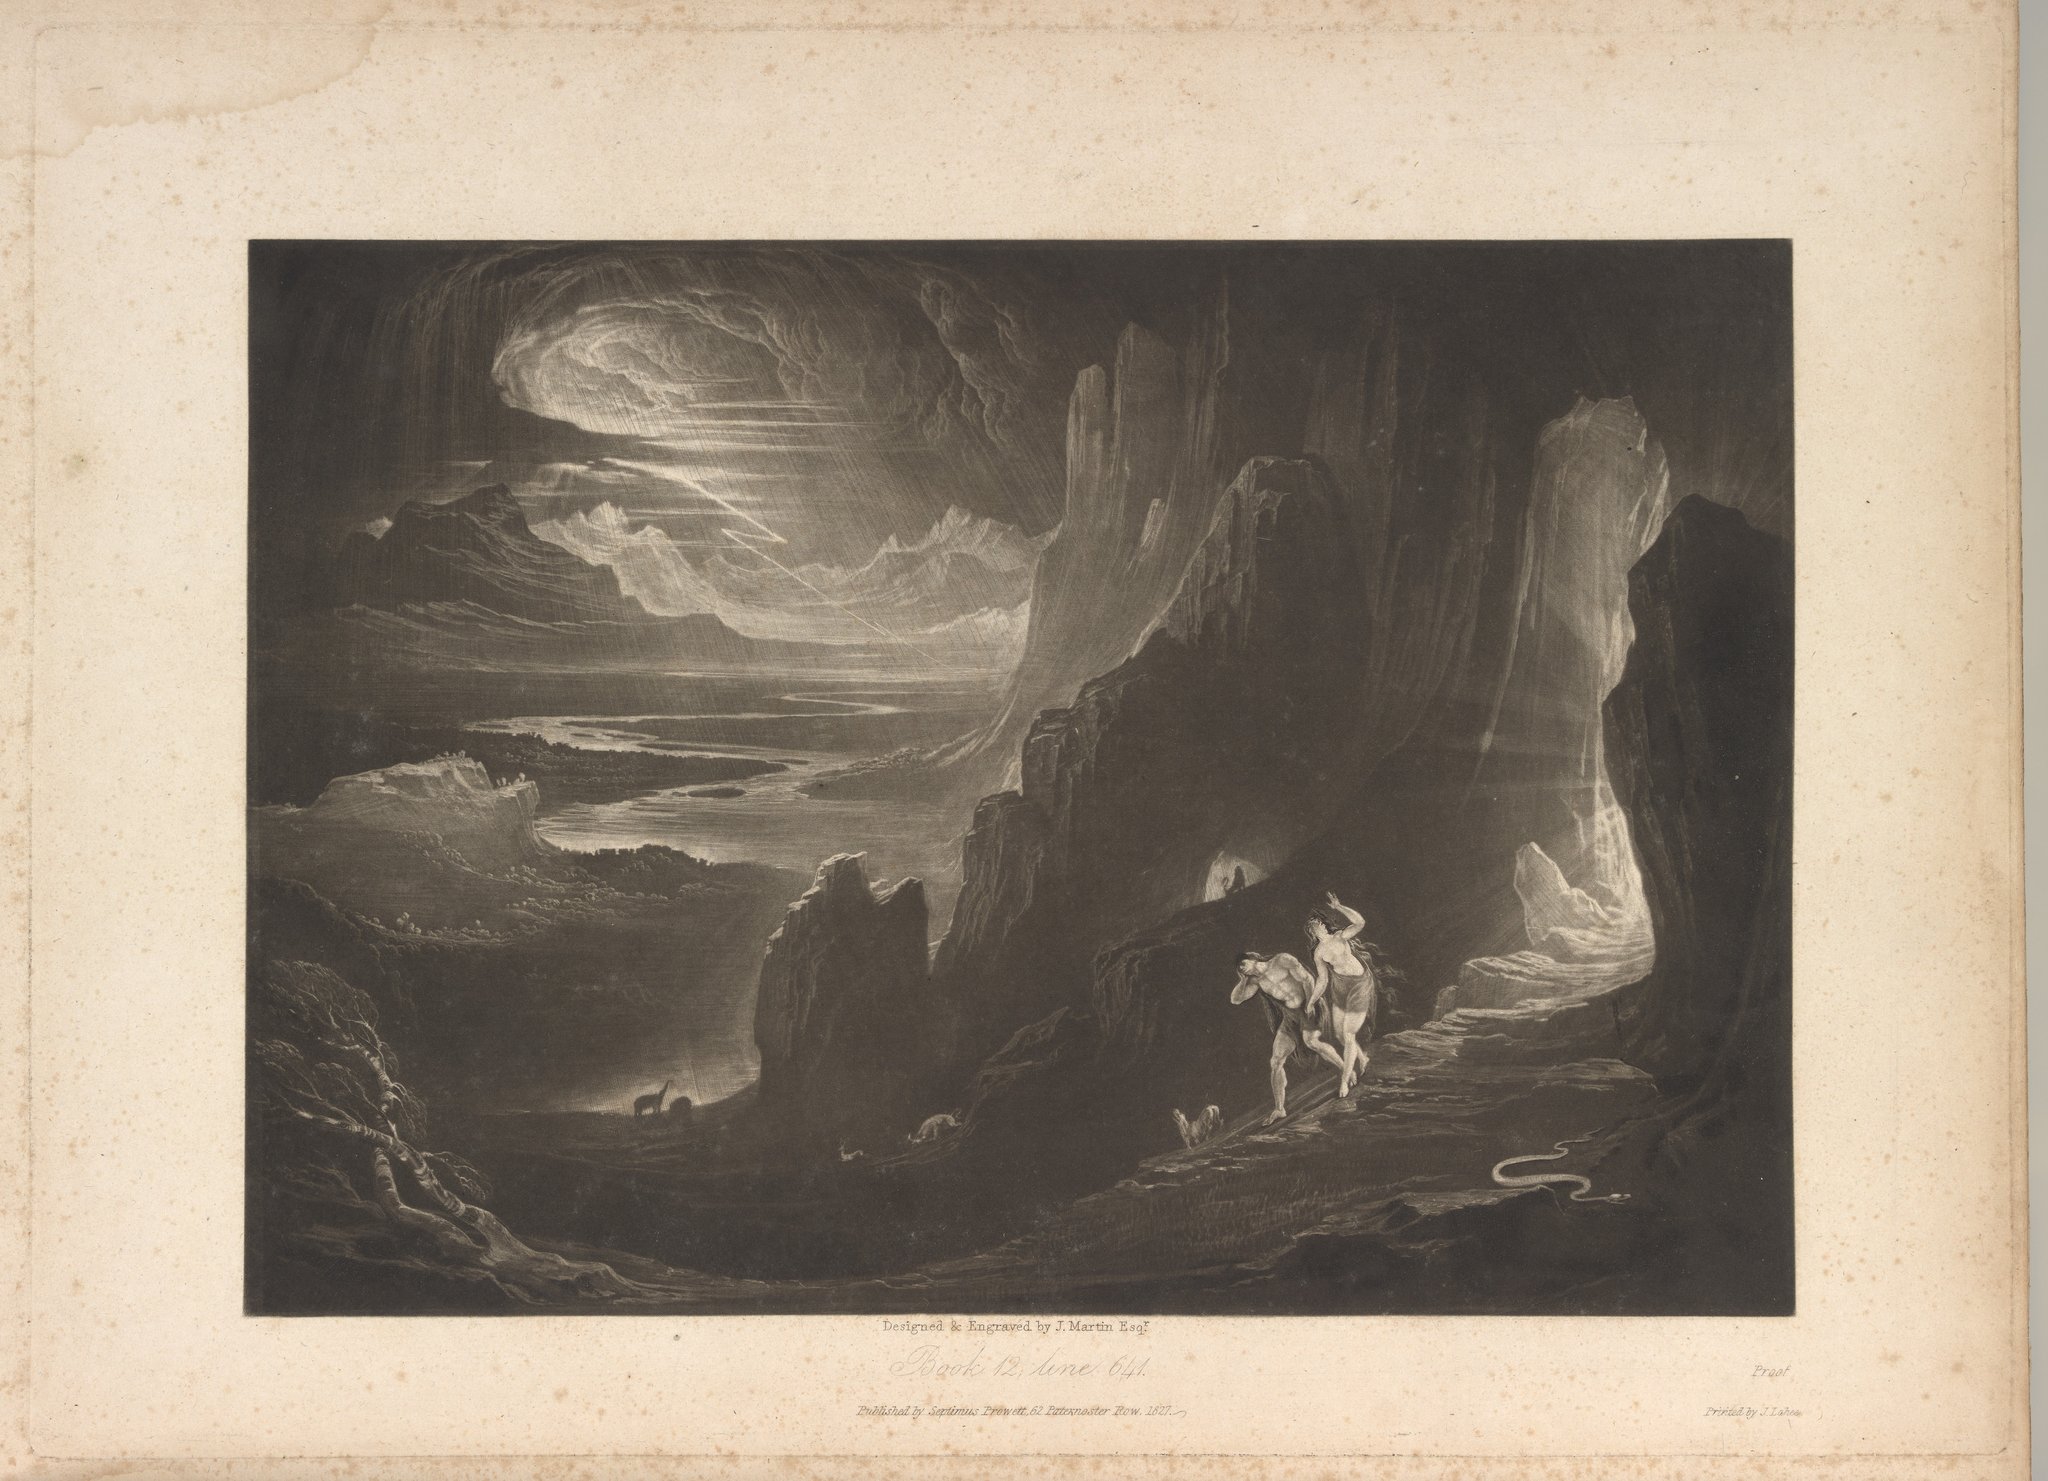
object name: book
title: The Paradise Lost of John Milton with Illustrations by John Martin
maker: john martin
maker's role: artist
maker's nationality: british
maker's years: 1789-1854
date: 1846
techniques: mezzotint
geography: england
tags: snakes,landscapes,adam,eve